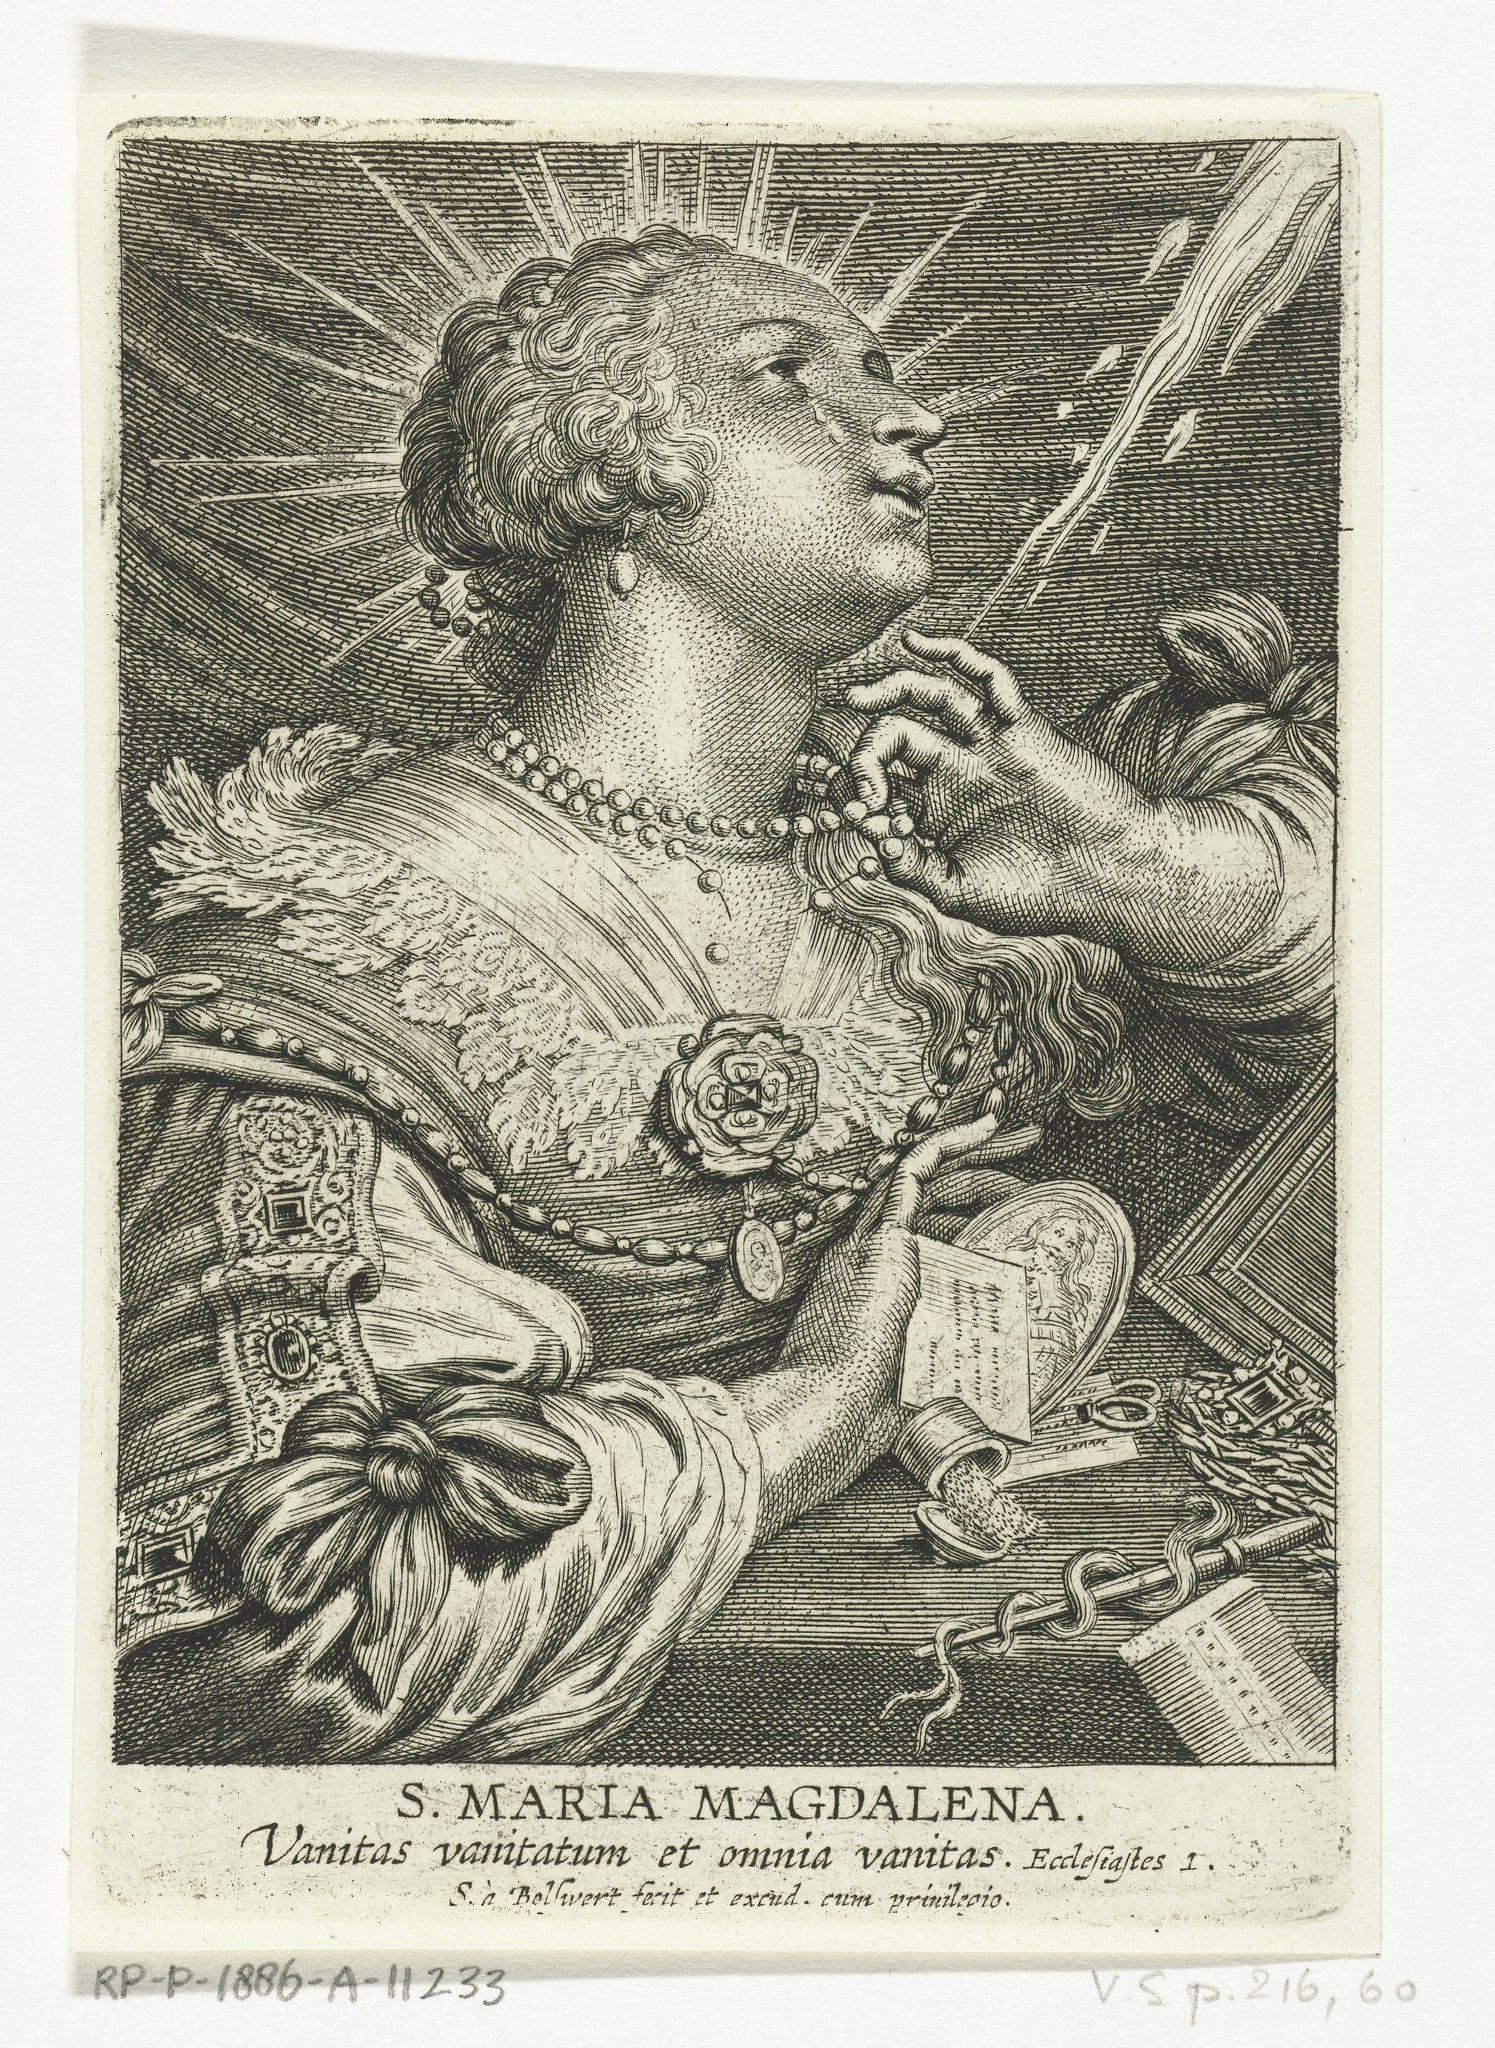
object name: print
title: S. Maria Magdalena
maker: schelte adamsz. bolswert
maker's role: print maker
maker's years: 1586-1659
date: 1596-1659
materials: paper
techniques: engraving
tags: st. mary magdalene renounces the vanities of the world, laying aside her jewels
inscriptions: collector's mark: Lugt 2228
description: Prent uit serie Vélins met negentig prenten naar ontwerp van Peter Paul Rubens. In de bronnen vinden we uiteenlopende gegevens over aantal en samenstelling van de serie. Hollstein hanteert het aantal van negentig prenten. De reeks Vélins in de collectie van het RMA bevat verschillende staten afkomstig uit meerdere uitgaven welke moeilijk te duiden zijn. Sommige dragen het originele adres van Schelte Adamsz. Bolswert als graveur en uitgever, op andere exemplaren is deze naam verwijderd (duidelijk zichtbaar!) en vervangen door de naam Cornelis Galle (II). De prenten met de naam van uitgever Galle zijn vaak opgewerkt. We treffen nog een andere naam van een uitgever bij enkele prent aan: Martien van den Enden. Herkomst uit meerdere uitgaven spreekt ook uit afwijkende opschriften in Nederlands en Latijn en variaties op dezelfde thema's welke misschien nooit langs elkaar in dezelfde serie gebruikt werden.